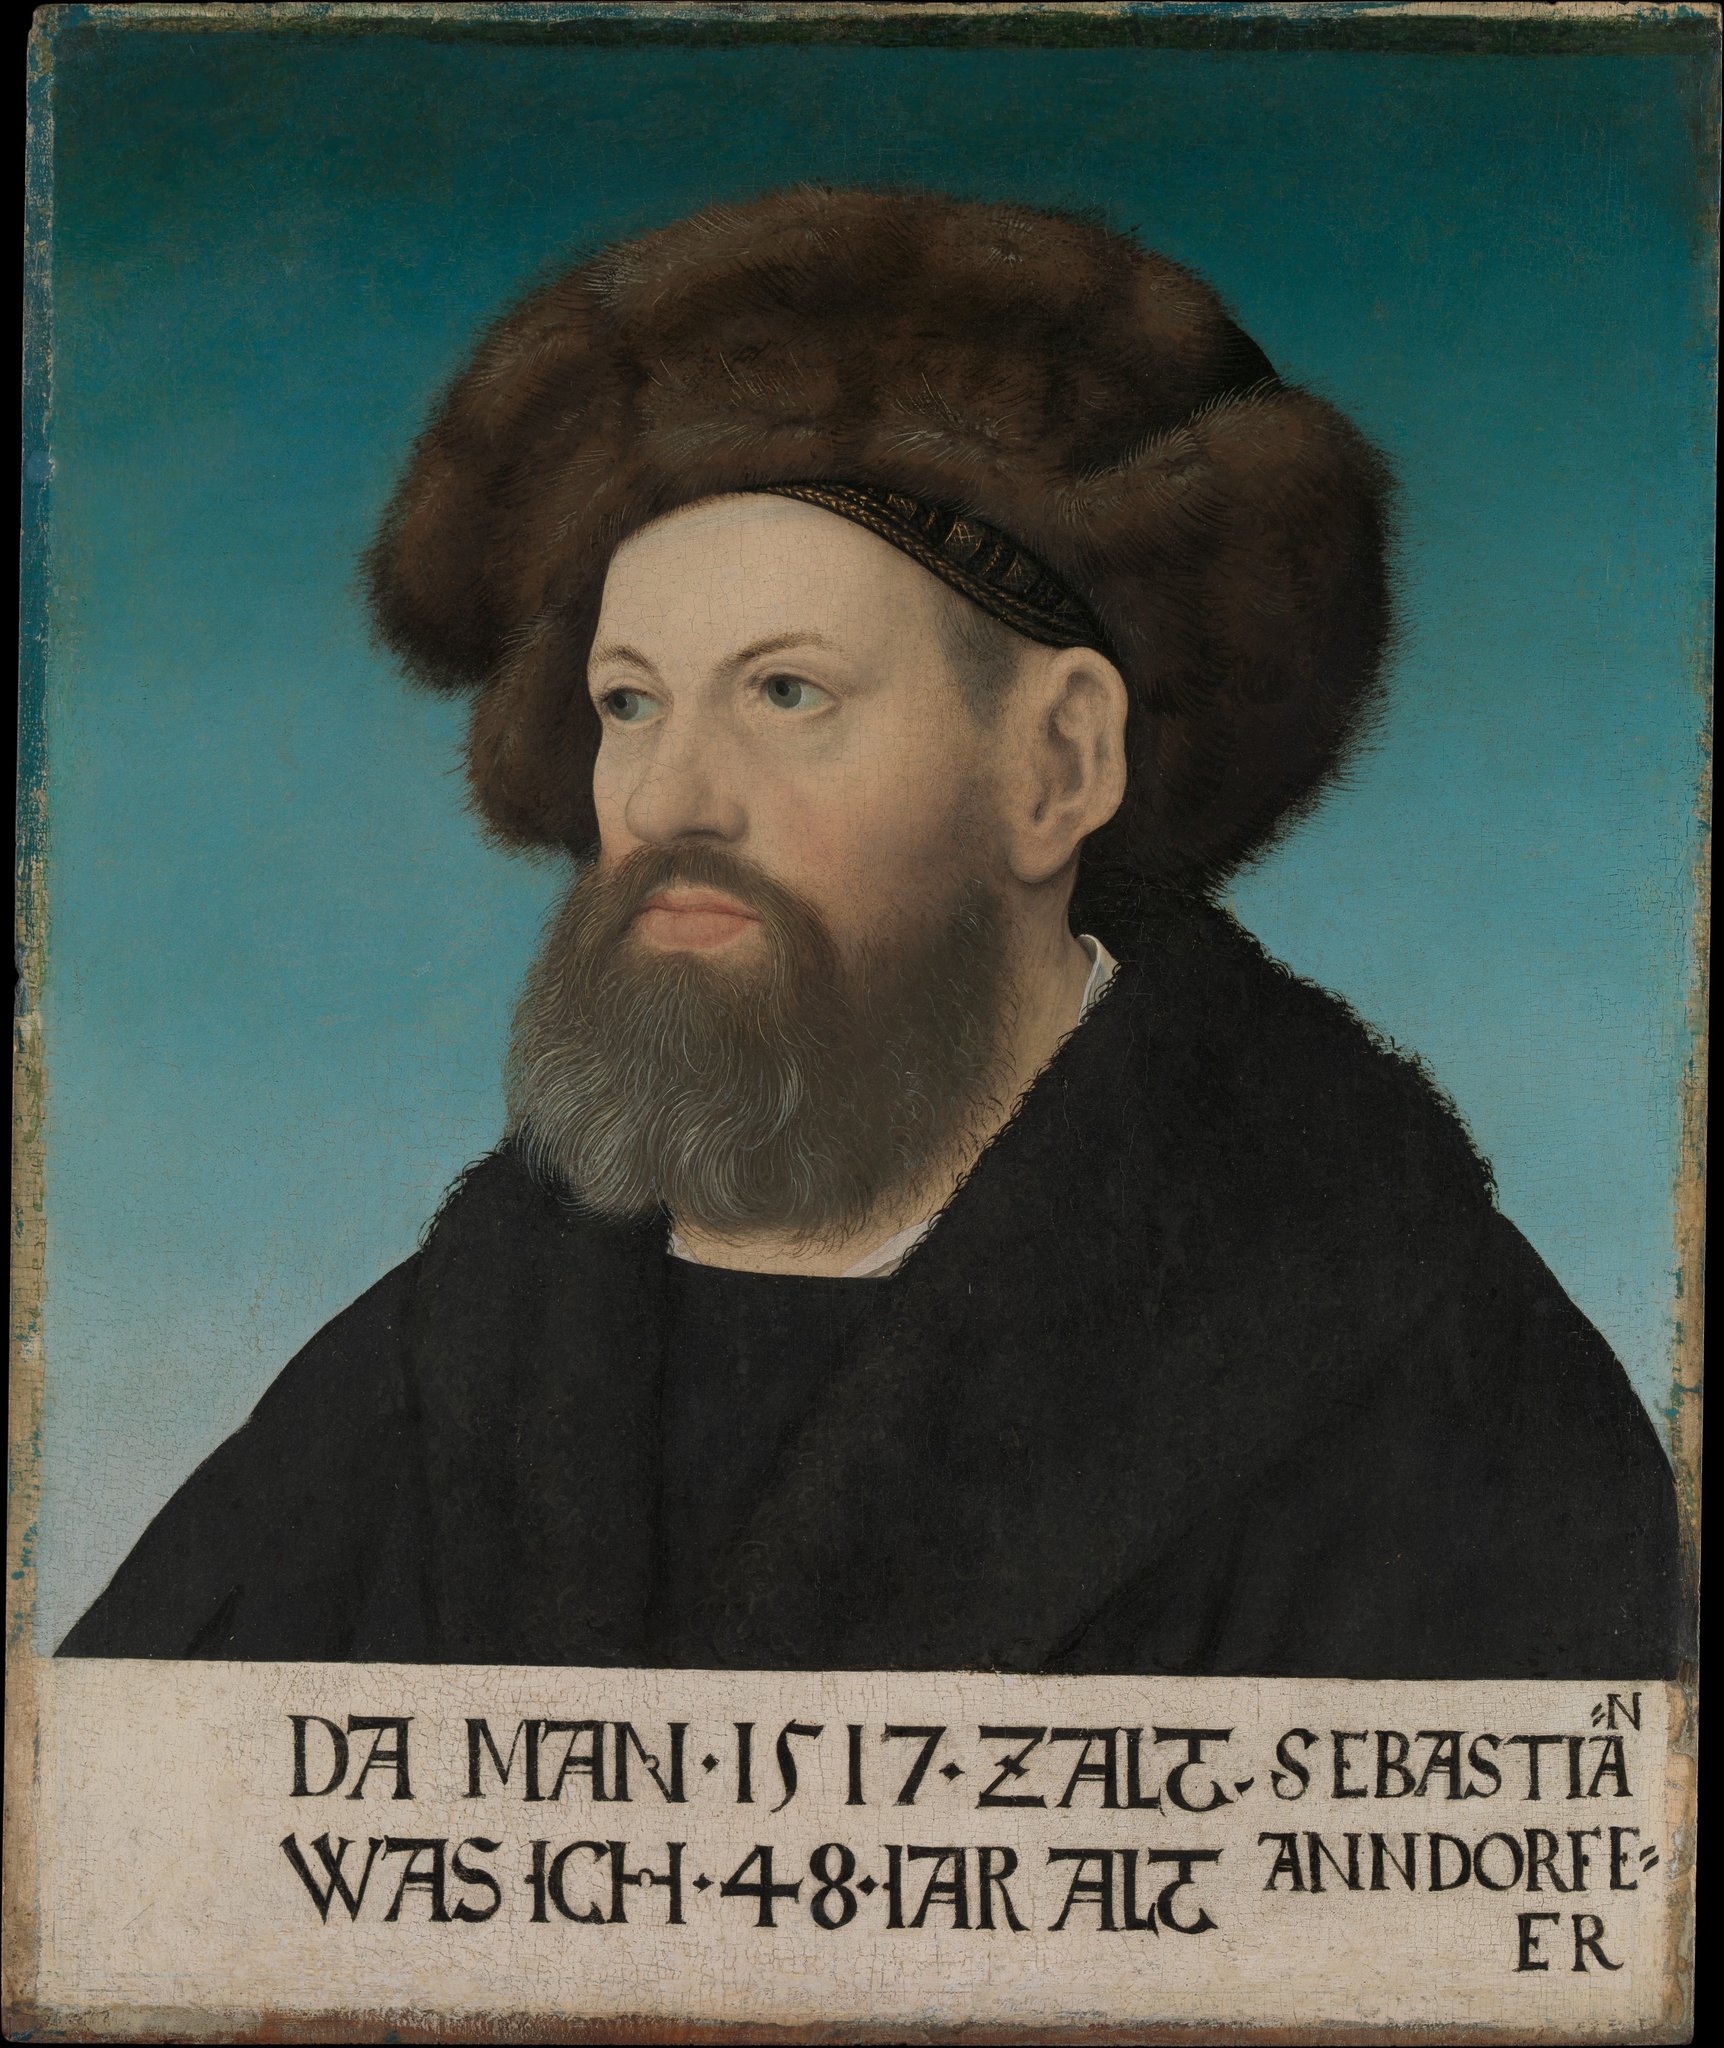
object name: painting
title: Sebastian Andorfer (1469–1537)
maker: hans maler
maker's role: artist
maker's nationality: german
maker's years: 1475-1529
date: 1517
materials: oil, wood, stone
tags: men,portraits